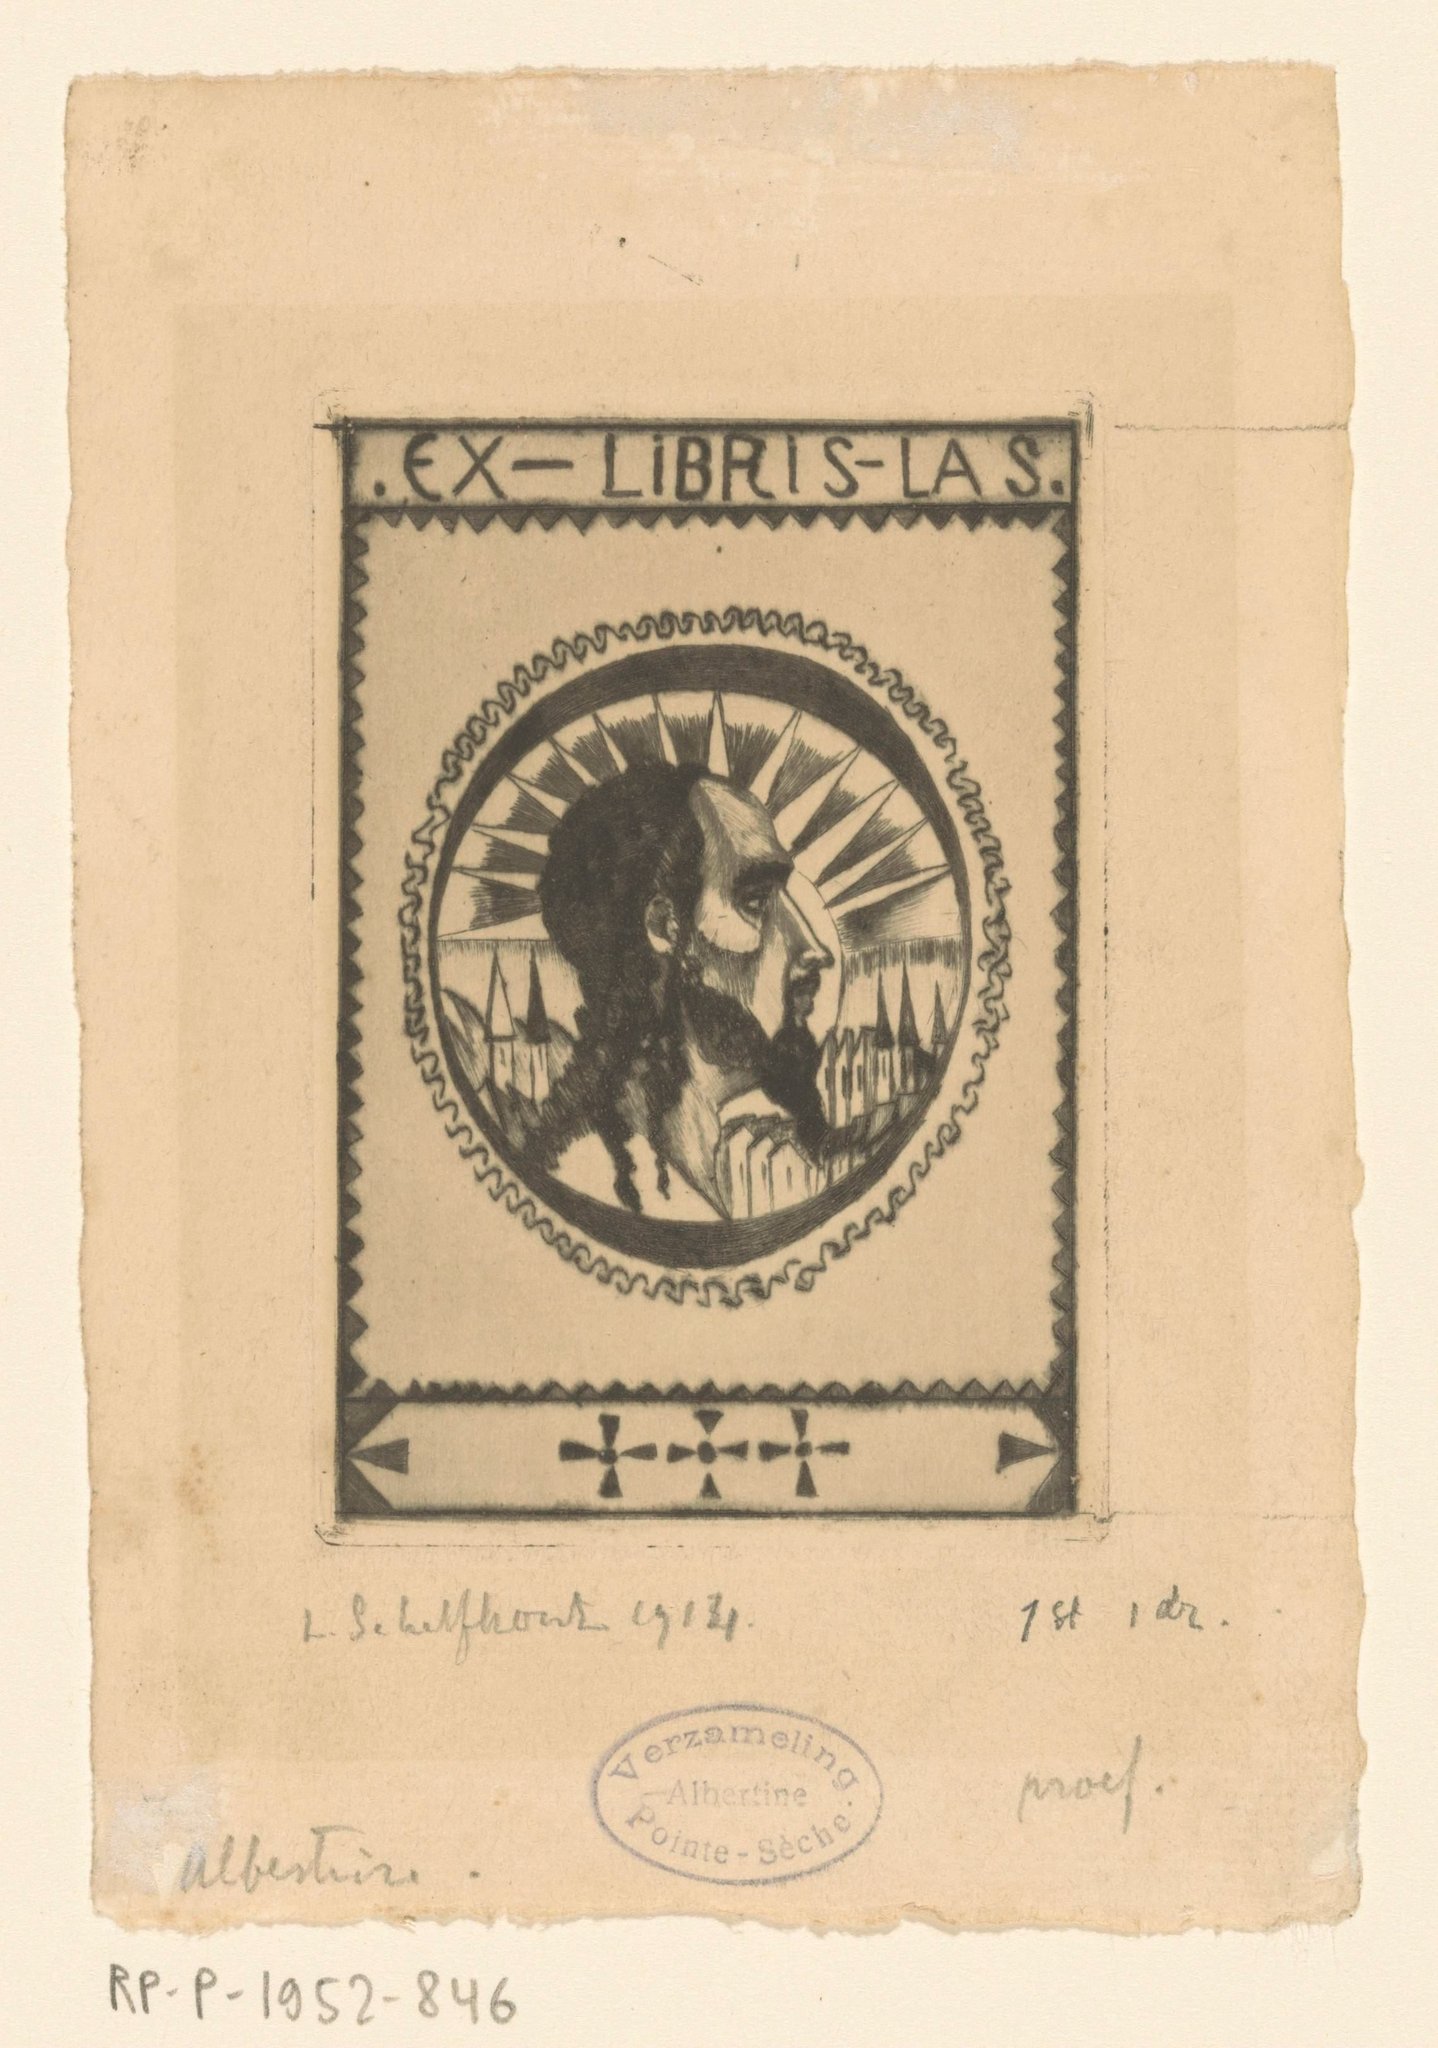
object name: bookplate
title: Ex libris van Lodewijk Schelfhout en Albertine van der Meulen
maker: lodewijk schelfhout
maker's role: draughtsman, print maker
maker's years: 1881-1943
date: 1914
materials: paper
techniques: drypoint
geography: netherlands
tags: amsterdam, albertine elisabeth schelfhout-van der meulen, the hague, print maker, draughtsman, lodewijk schelfhout, rays as nimbus, christ as adult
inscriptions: collector's mark: Lugt 5i, collector's mark: Lugt 2760, collector's mark: Lugt 2228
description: Het hoofd van Christus, omgeven door lichtstralen. Op de achtergrond kerktorens.